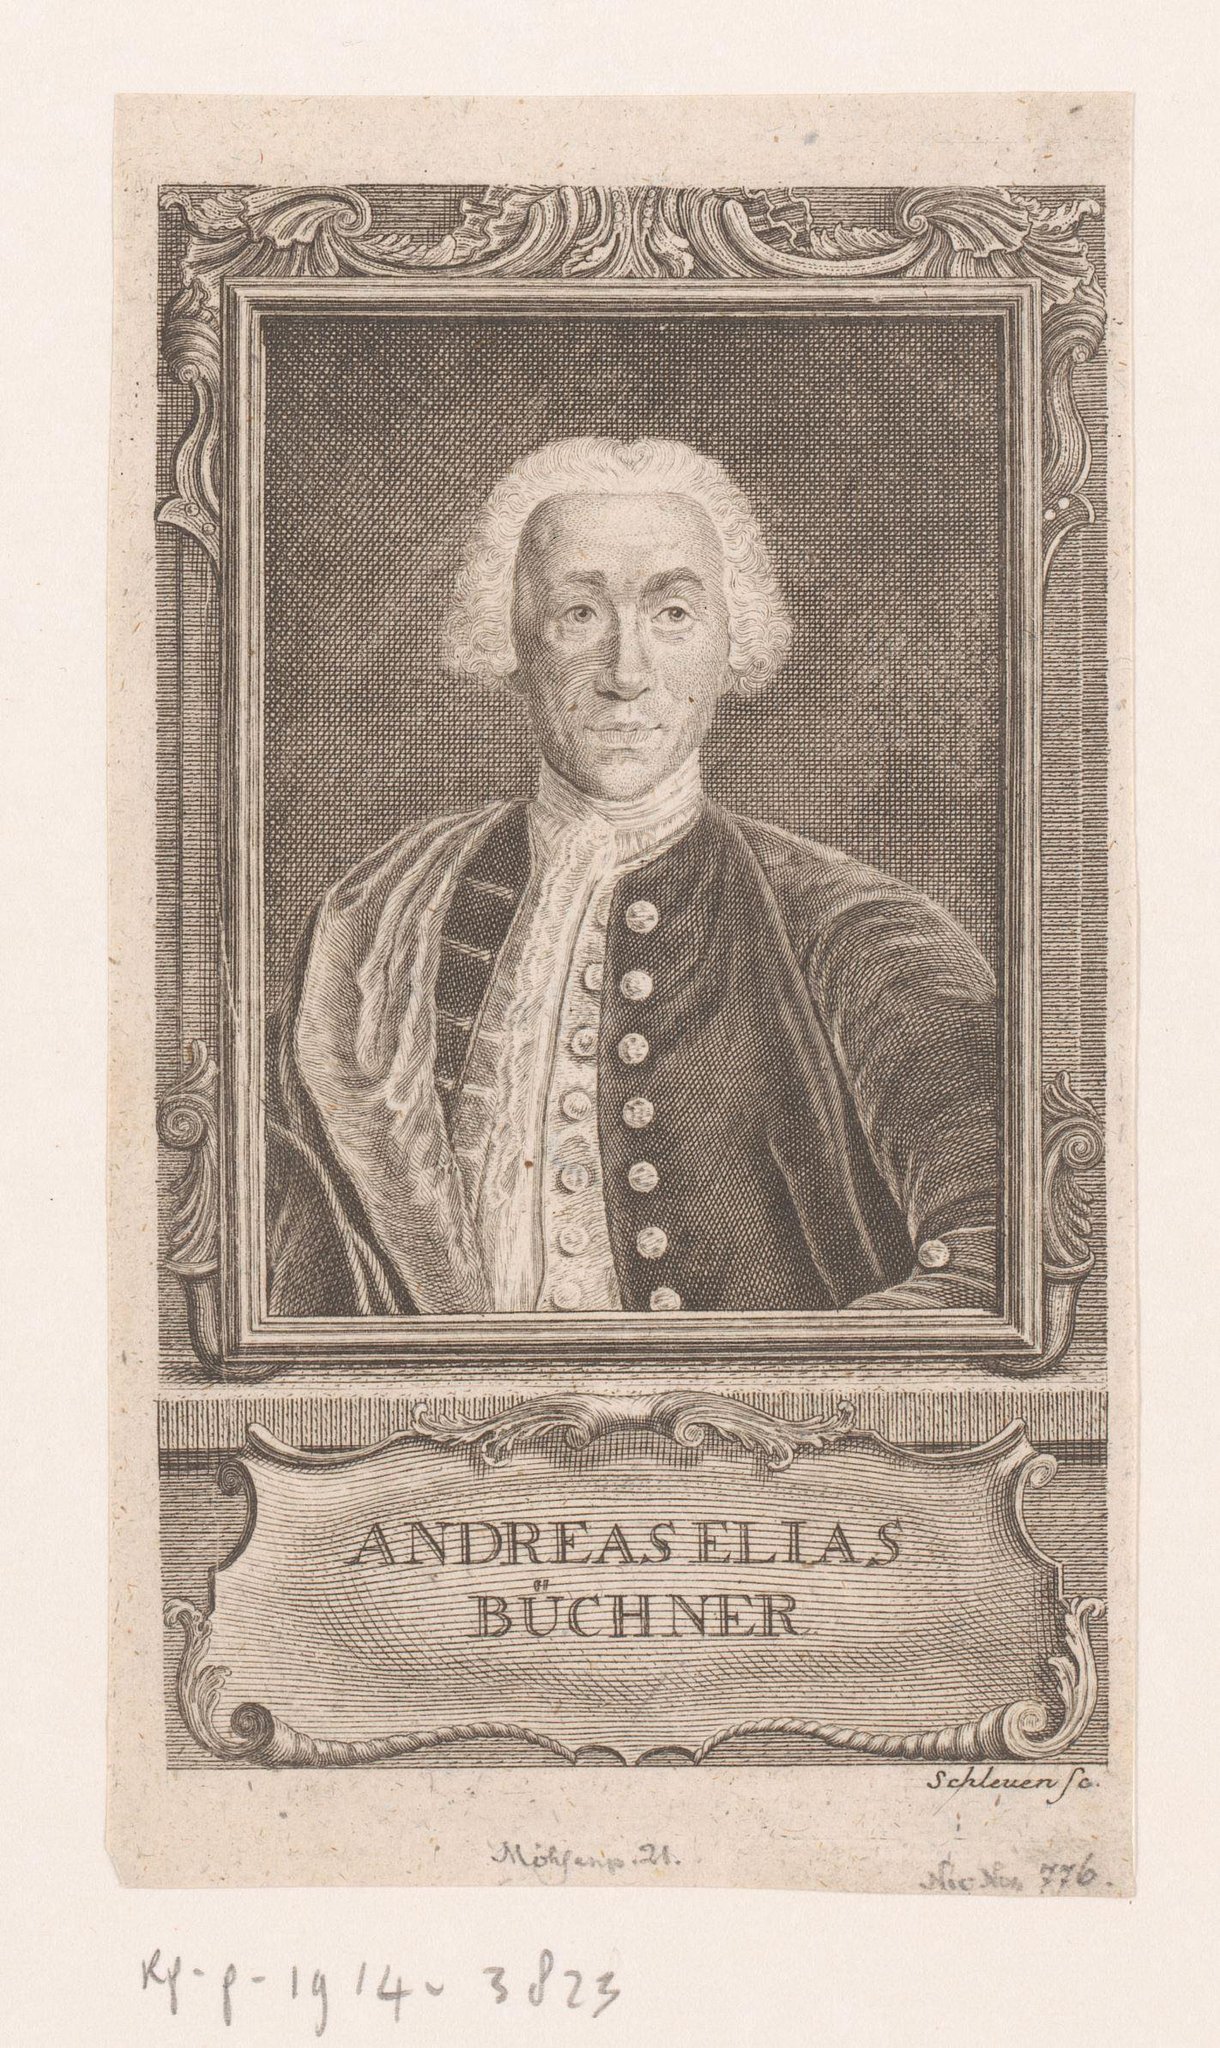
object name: print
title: Portret van Andreas Elias Büchner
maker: johann friedrich schleuen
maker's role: print maker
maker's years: 1739-1784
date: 1749-1784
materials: paper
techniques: engraving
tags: historical persons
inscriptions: collector's mark: Lugt 2228